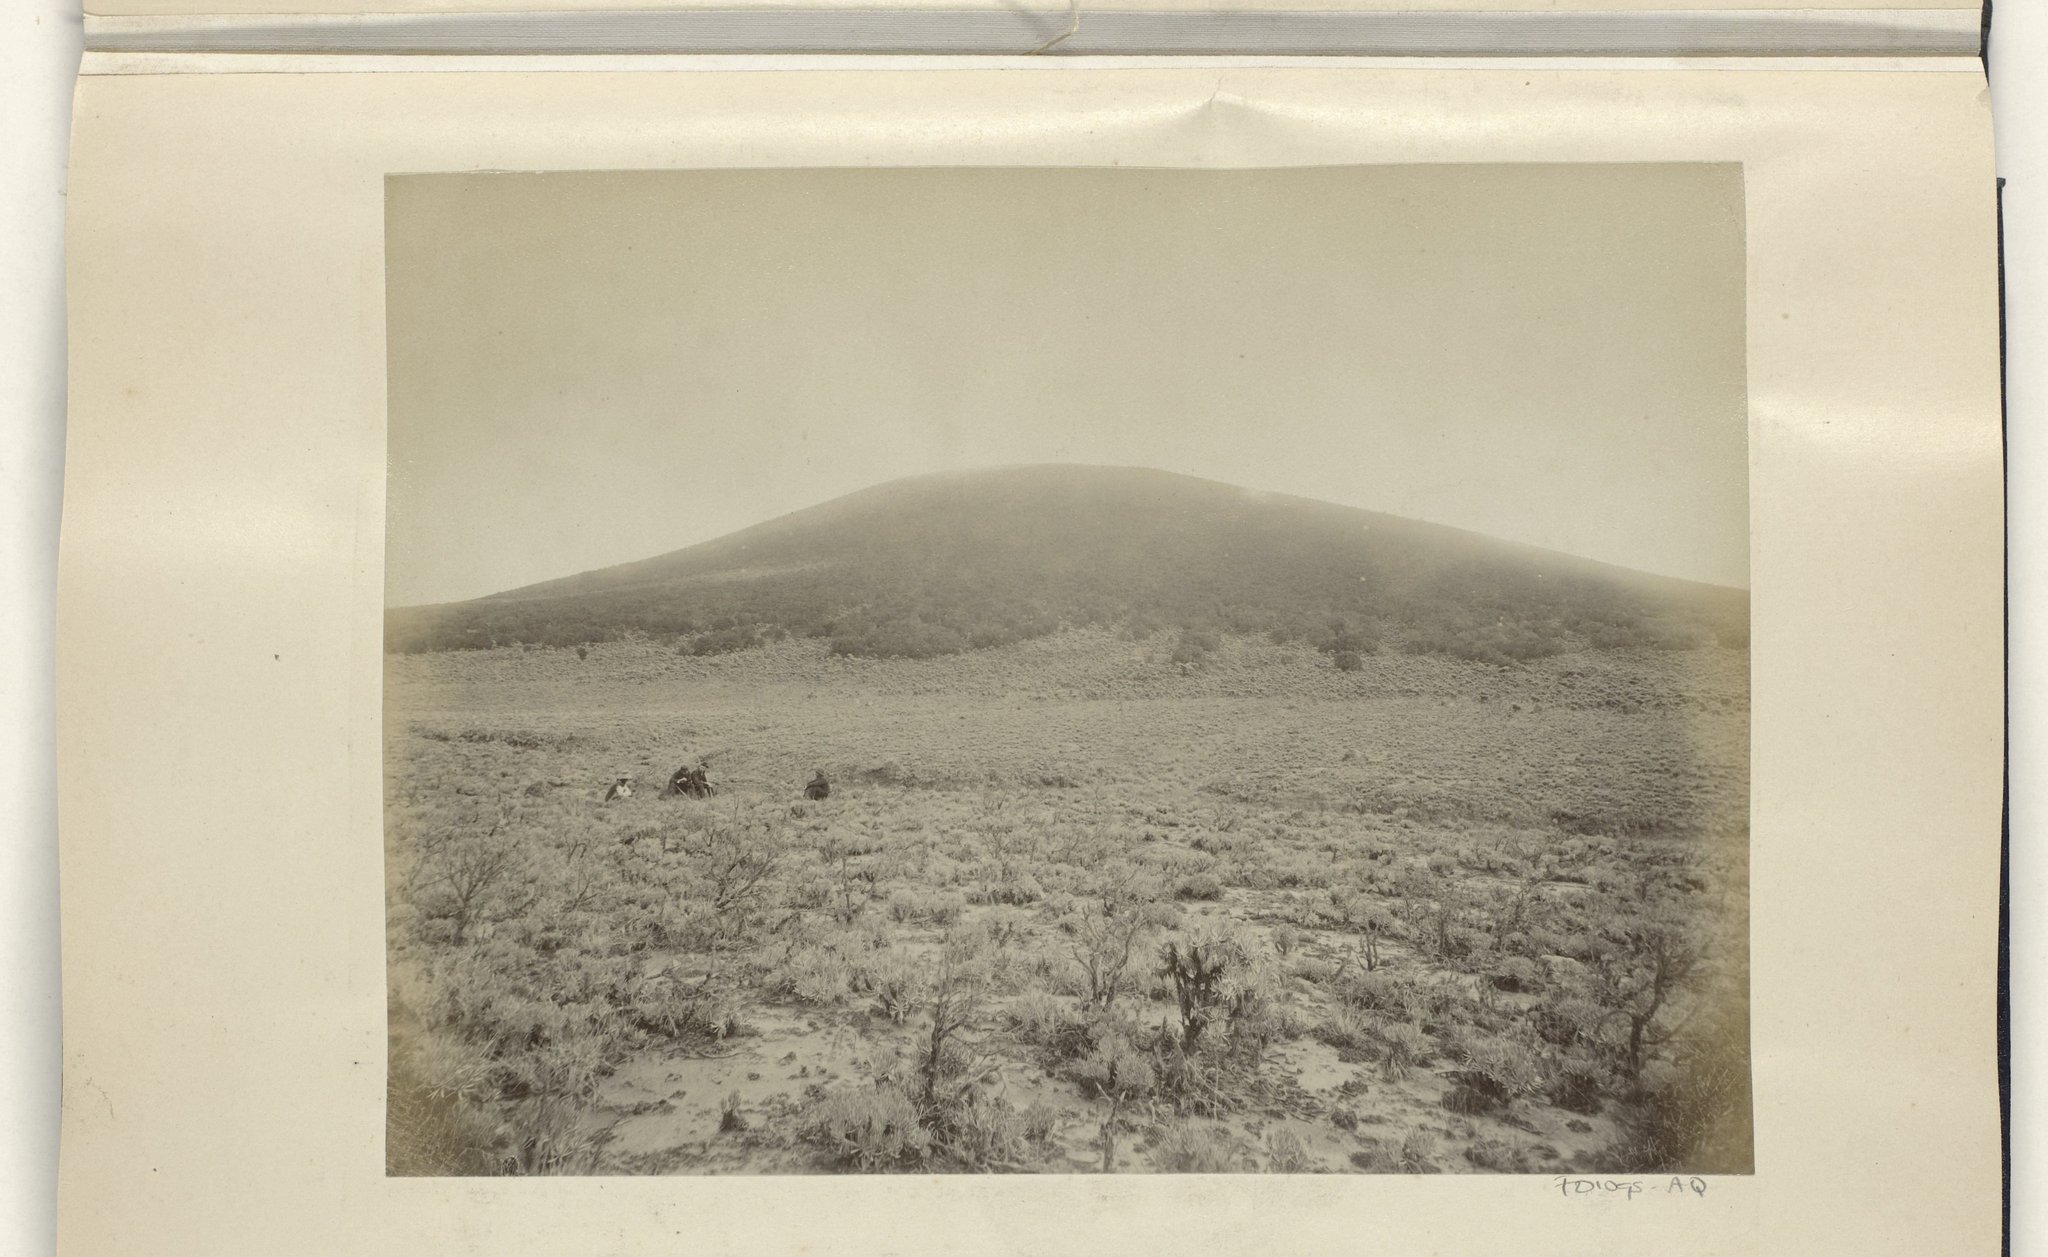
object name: photograph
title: Berglandschap met (vermoedelijk) Nederlanders in Nederlands-Indië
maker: Anonymous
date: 1895-1905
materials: paper, photographic support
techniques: albumen print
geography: dutch east indies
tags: mountain-top, peak (+ landscape with figures, staffage), dutch east indies, the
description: Onderdeel van Reisalbum met foto's van bezienswaardigheden in Italië, Zwitserland en Nederlands-Indië.